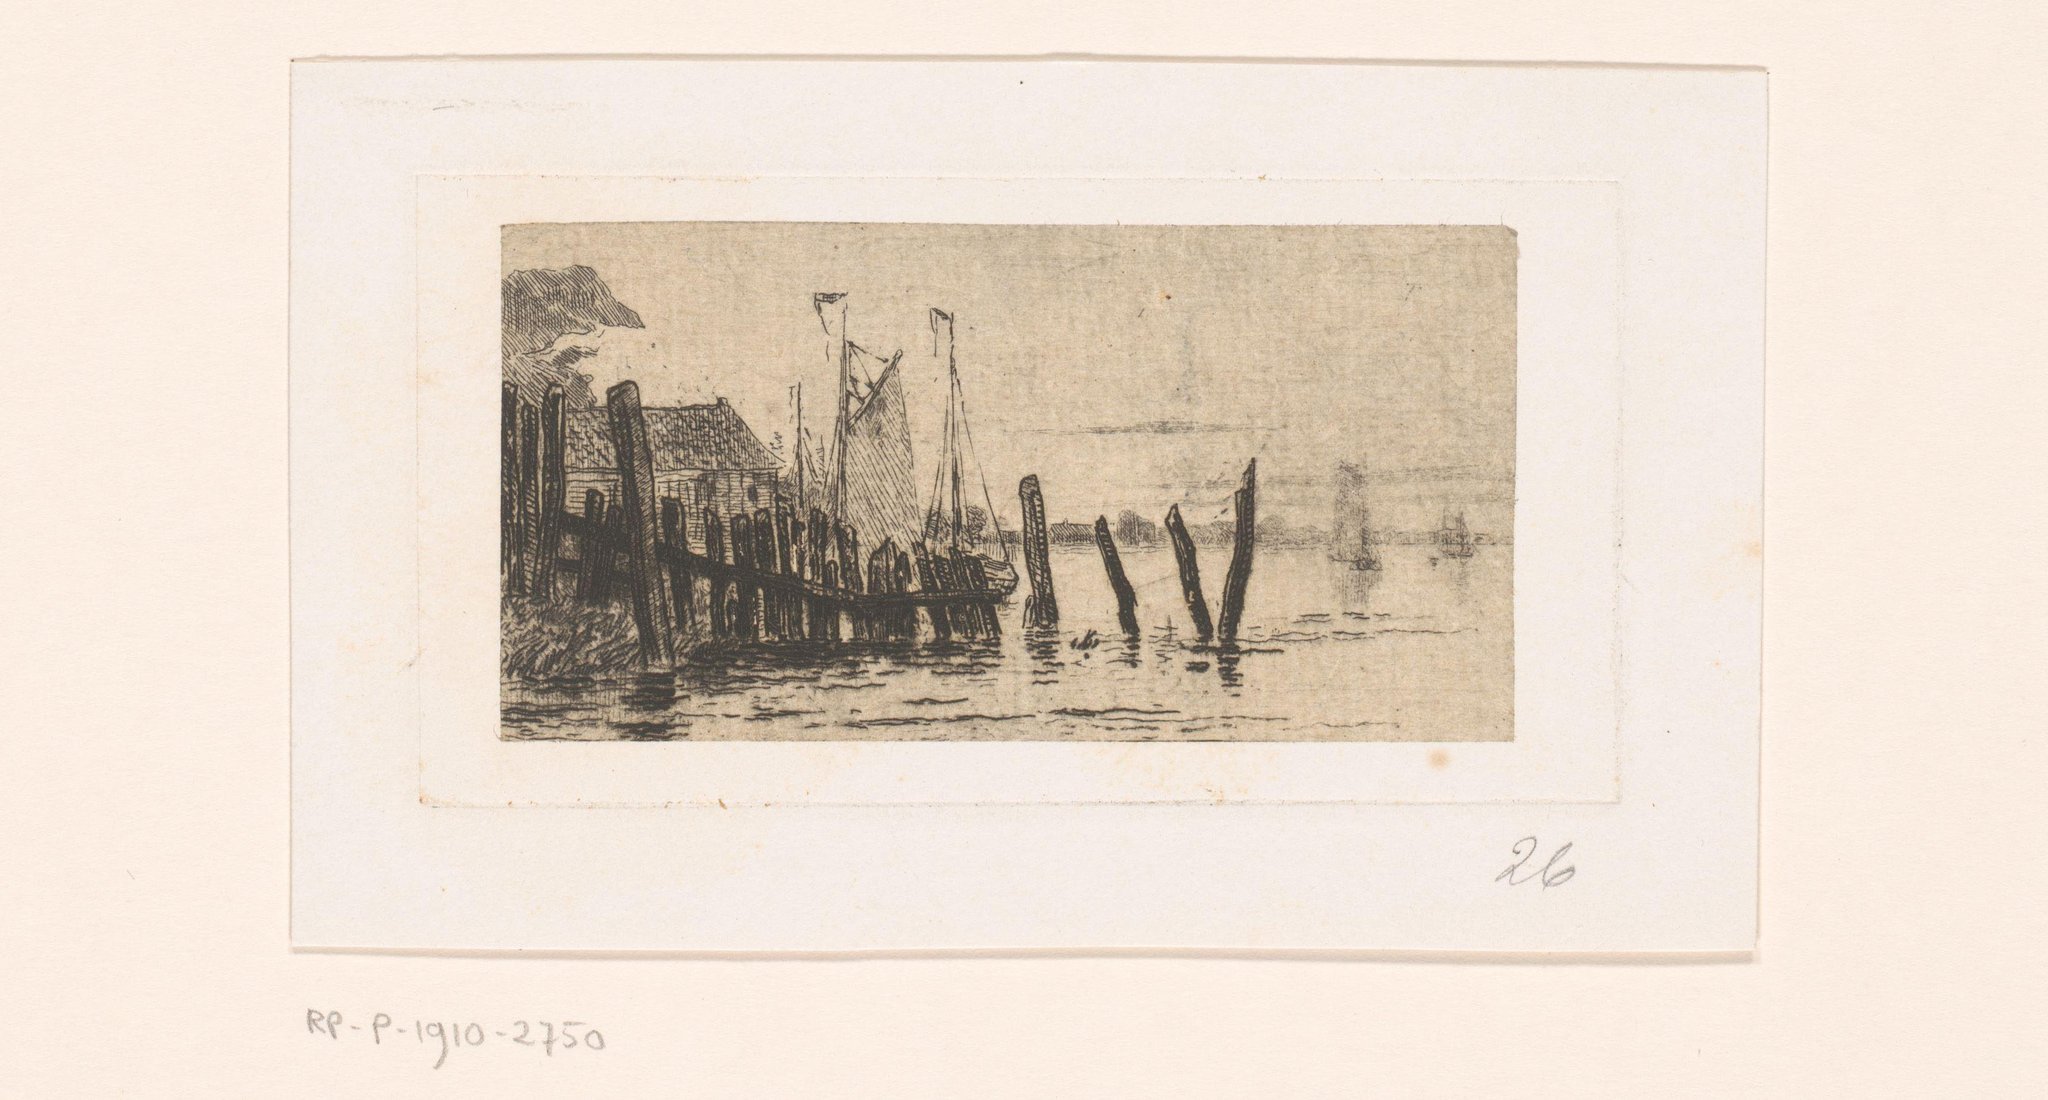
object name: print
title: L'estacade à Burght sur l'Escaut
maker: carel nicolaas storm van s-gravesande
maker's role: draughtsman, print maker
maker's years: 1841-1924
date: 1872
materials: paper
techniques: etching, intaglio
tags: river, pier, quay, wharf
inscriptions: collector's mark: Lugt 2228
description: Riviergezicht met links een staketsel. Op de achtergrond zeilboten.